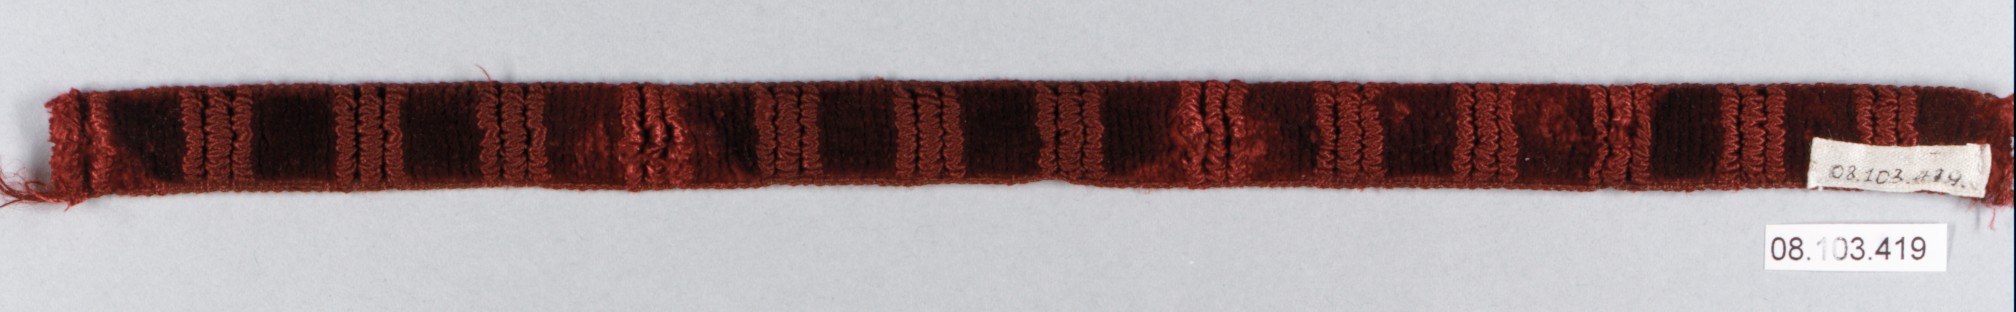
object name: galloon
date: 1601-1700